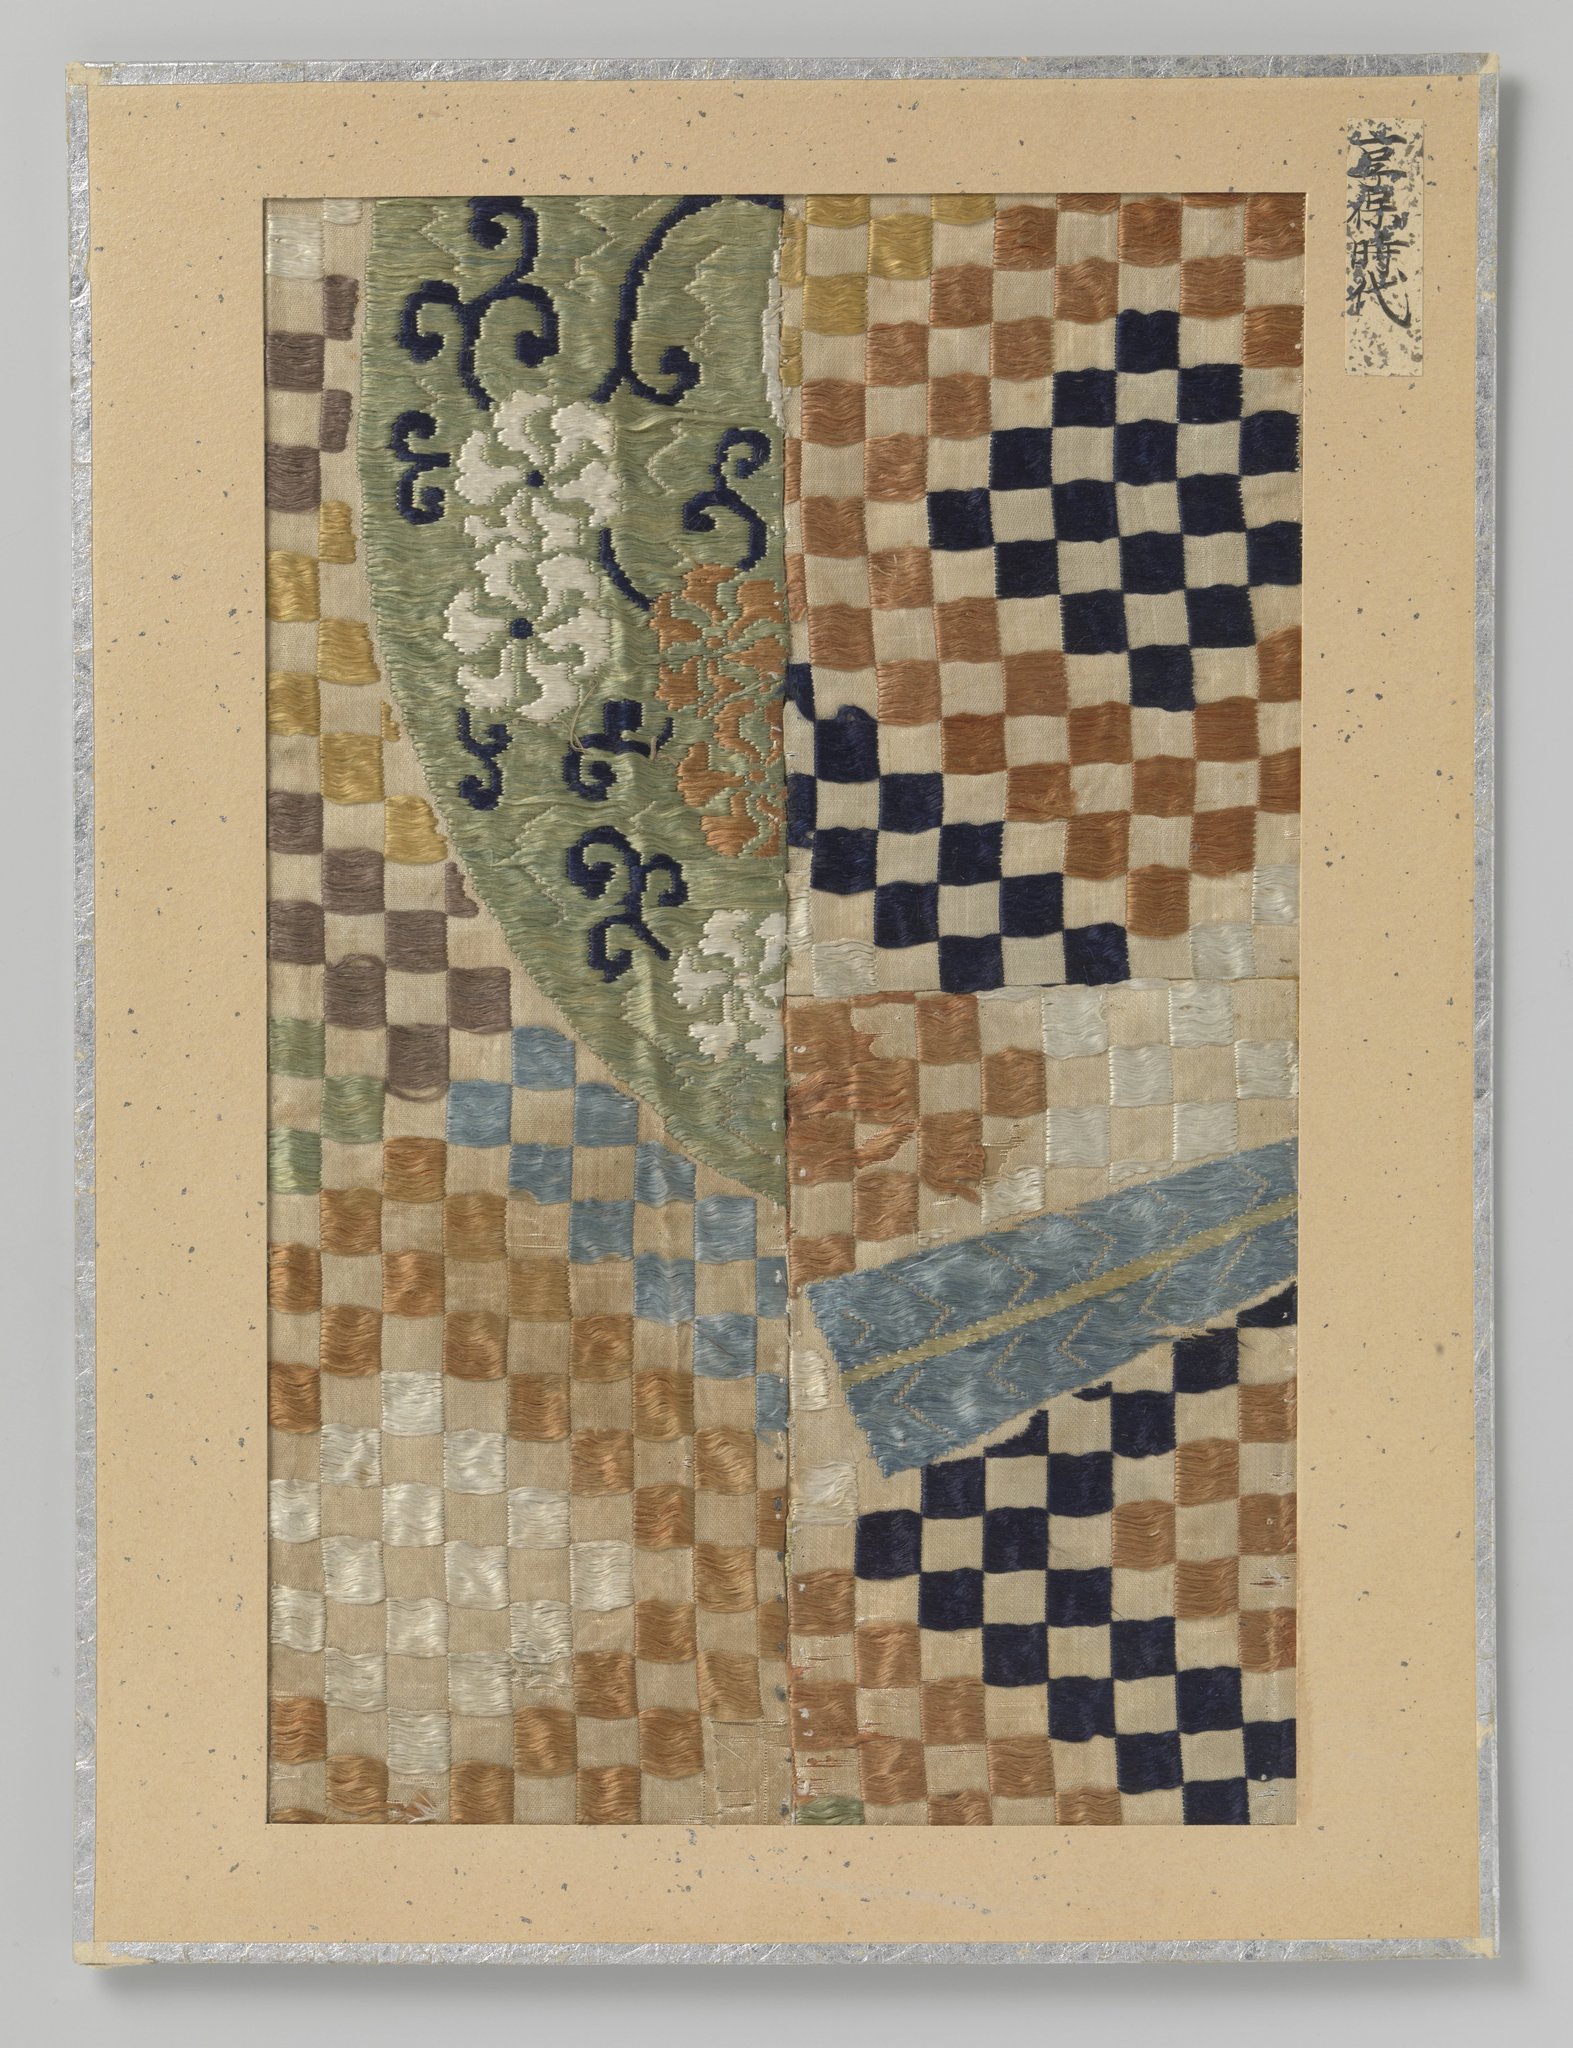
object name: textile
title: Fragment textiel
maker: Anonymous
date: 1716-1736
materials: silk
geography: japan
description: Textielfragment, borduursel van zuilen en bloemmotieven in kleuren.